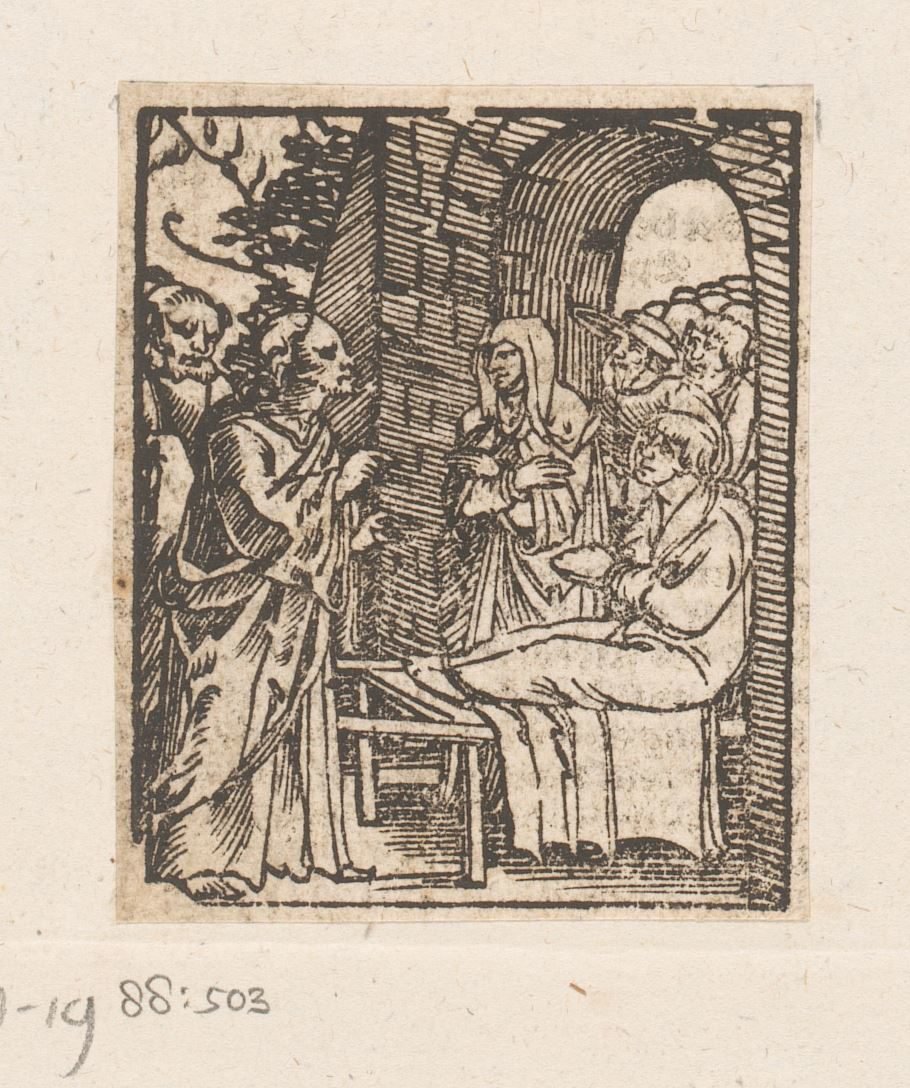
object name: print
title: Opwekking van de zoon van de weduwe van Nain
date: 1536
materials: paper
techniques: woodcut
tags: the son of the widow of nain is carried out of the city on a bier (luke 7:11-17)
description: Prent afkomstig uit: Evangelia und Epistel. Neurenberg: Hans Guldenmund, 1536.